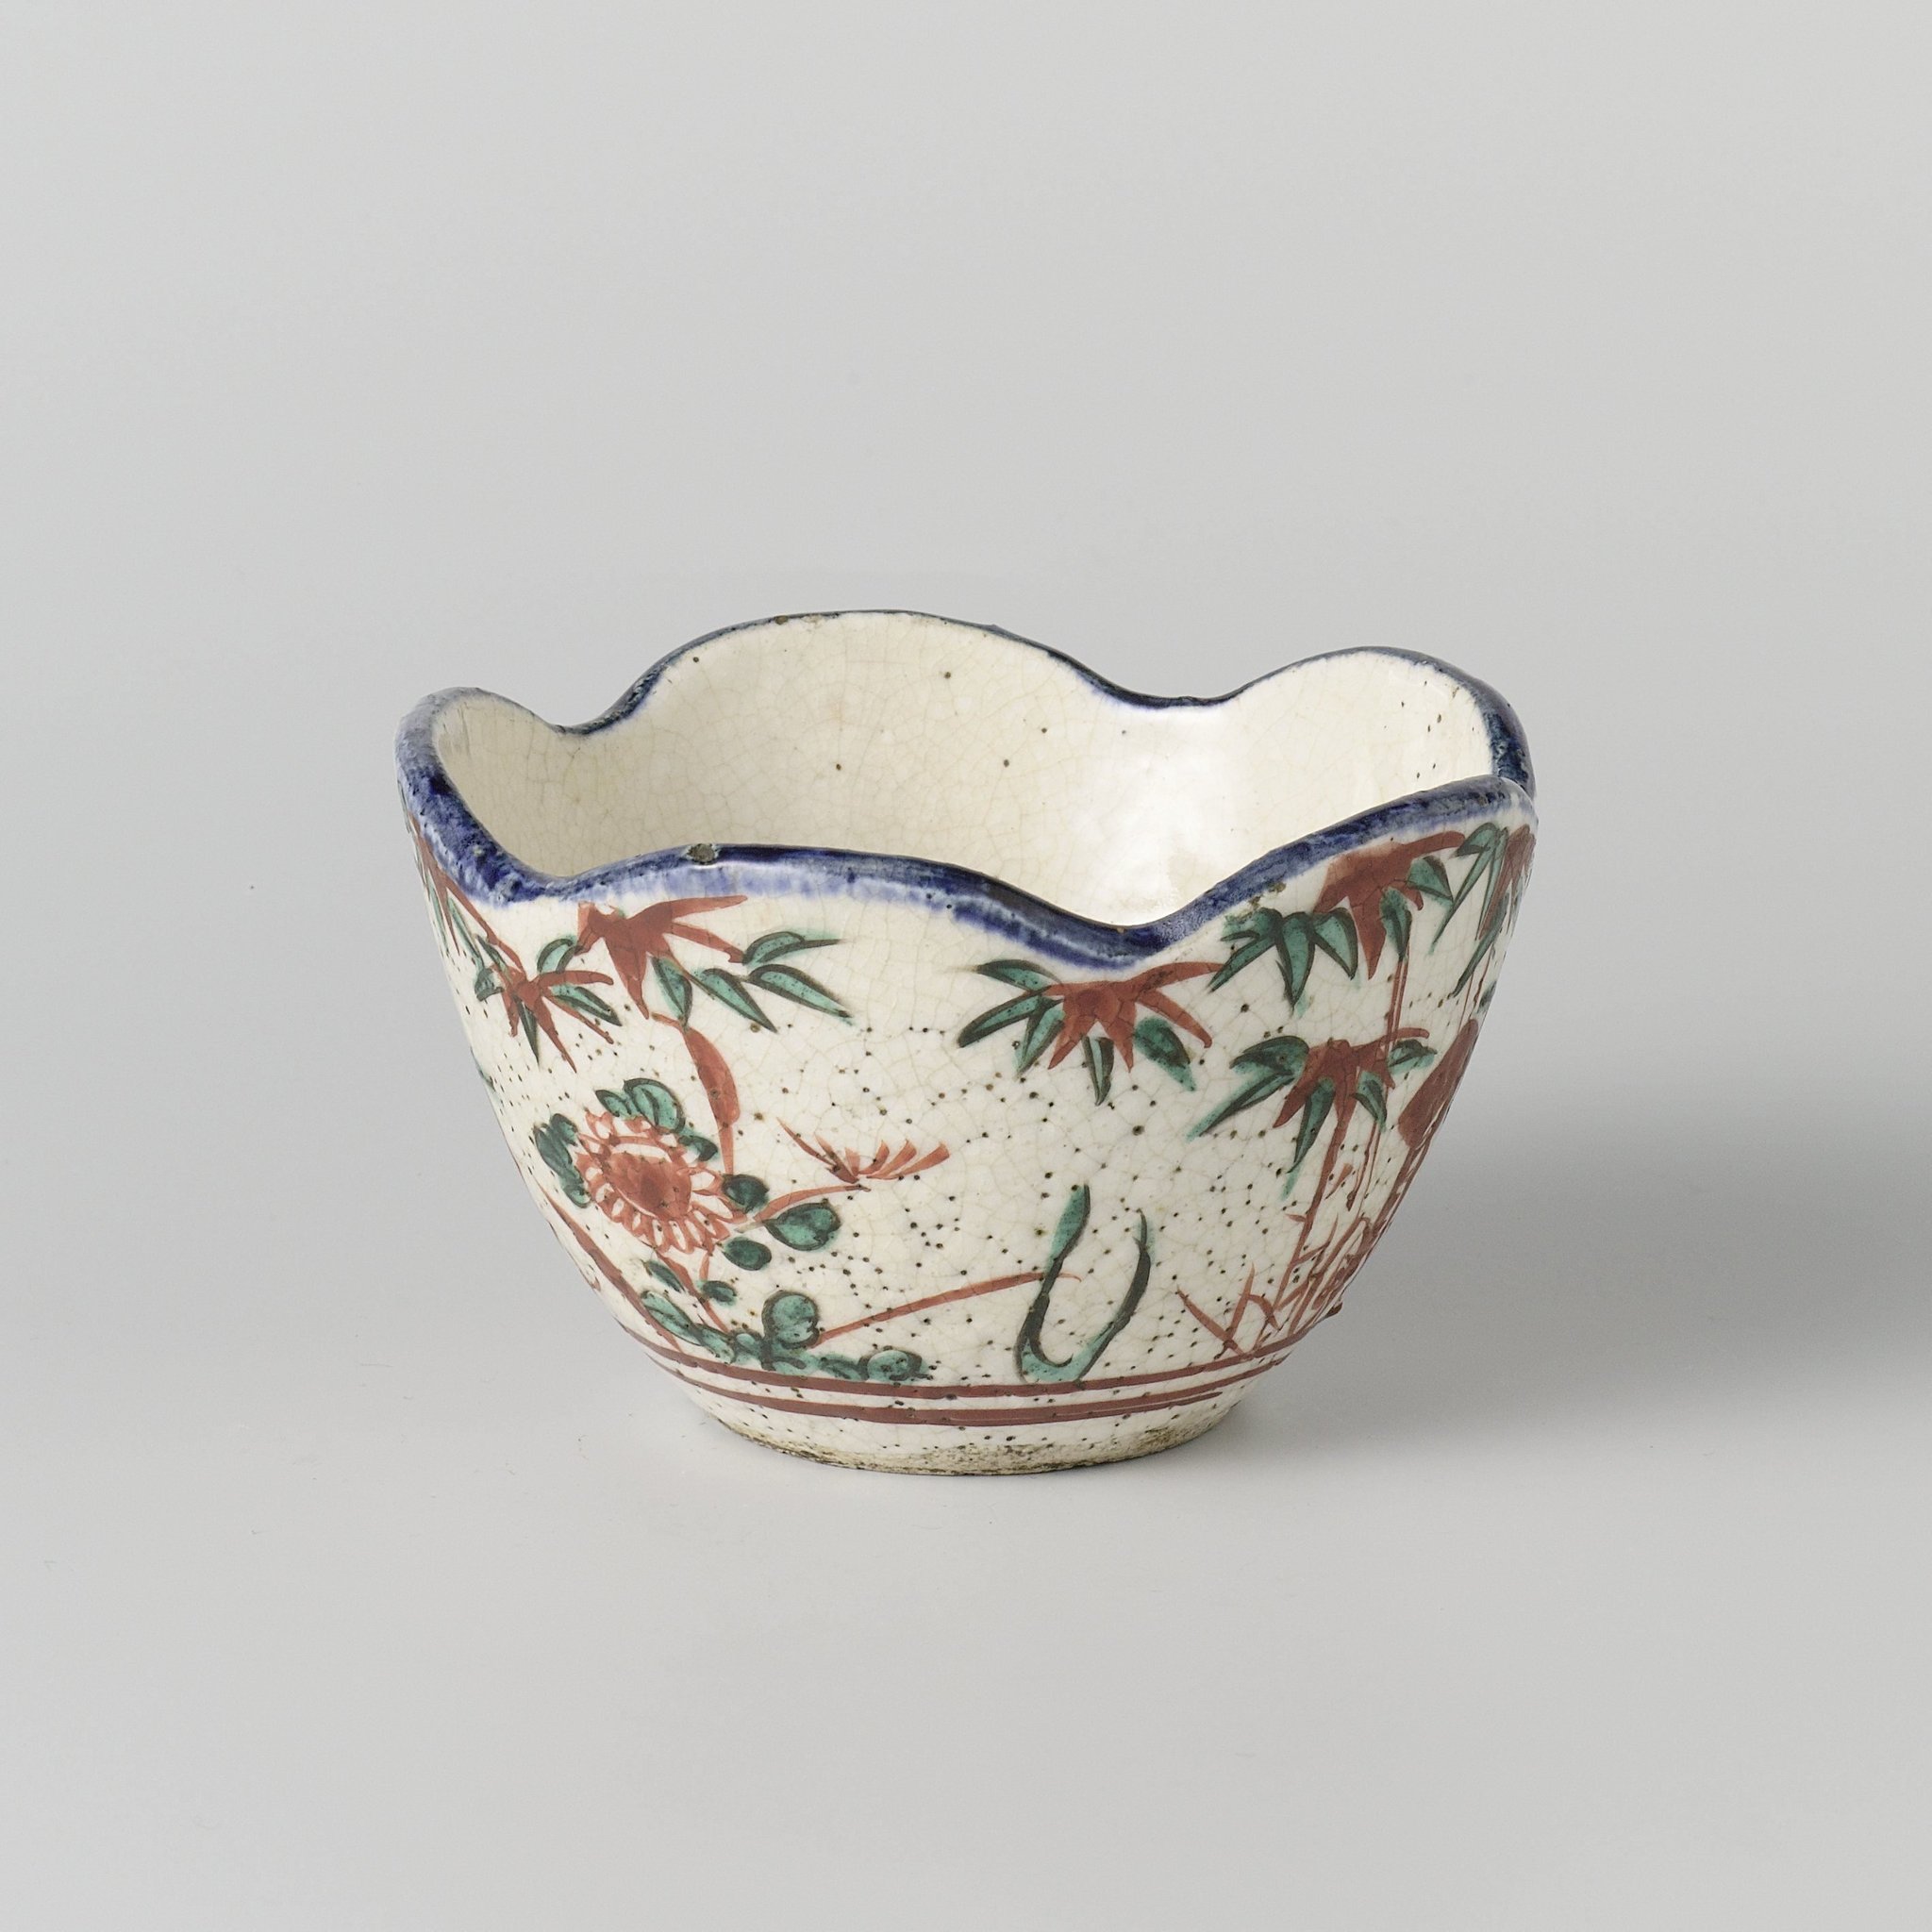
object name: bowl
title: Bowl with flowering plants and a landscape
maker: Anonymous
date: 1800-1900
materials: glaze, stoneware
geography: japan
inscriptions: signature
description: Kom van steengoed met een golvende rand, bedekt met een crèmekleurig glazuur en beschilderd in onderglazuur blauw en op het glazuur rood, groen en zwart. De buitenwand met bloeiende planten (bamboe, chrysant) en paddestoelen. Op de bodem een landschap met bergen en bomen. Gemerkt op de onderzijde met een ongeïdentificeerd karakter. Gyozan.